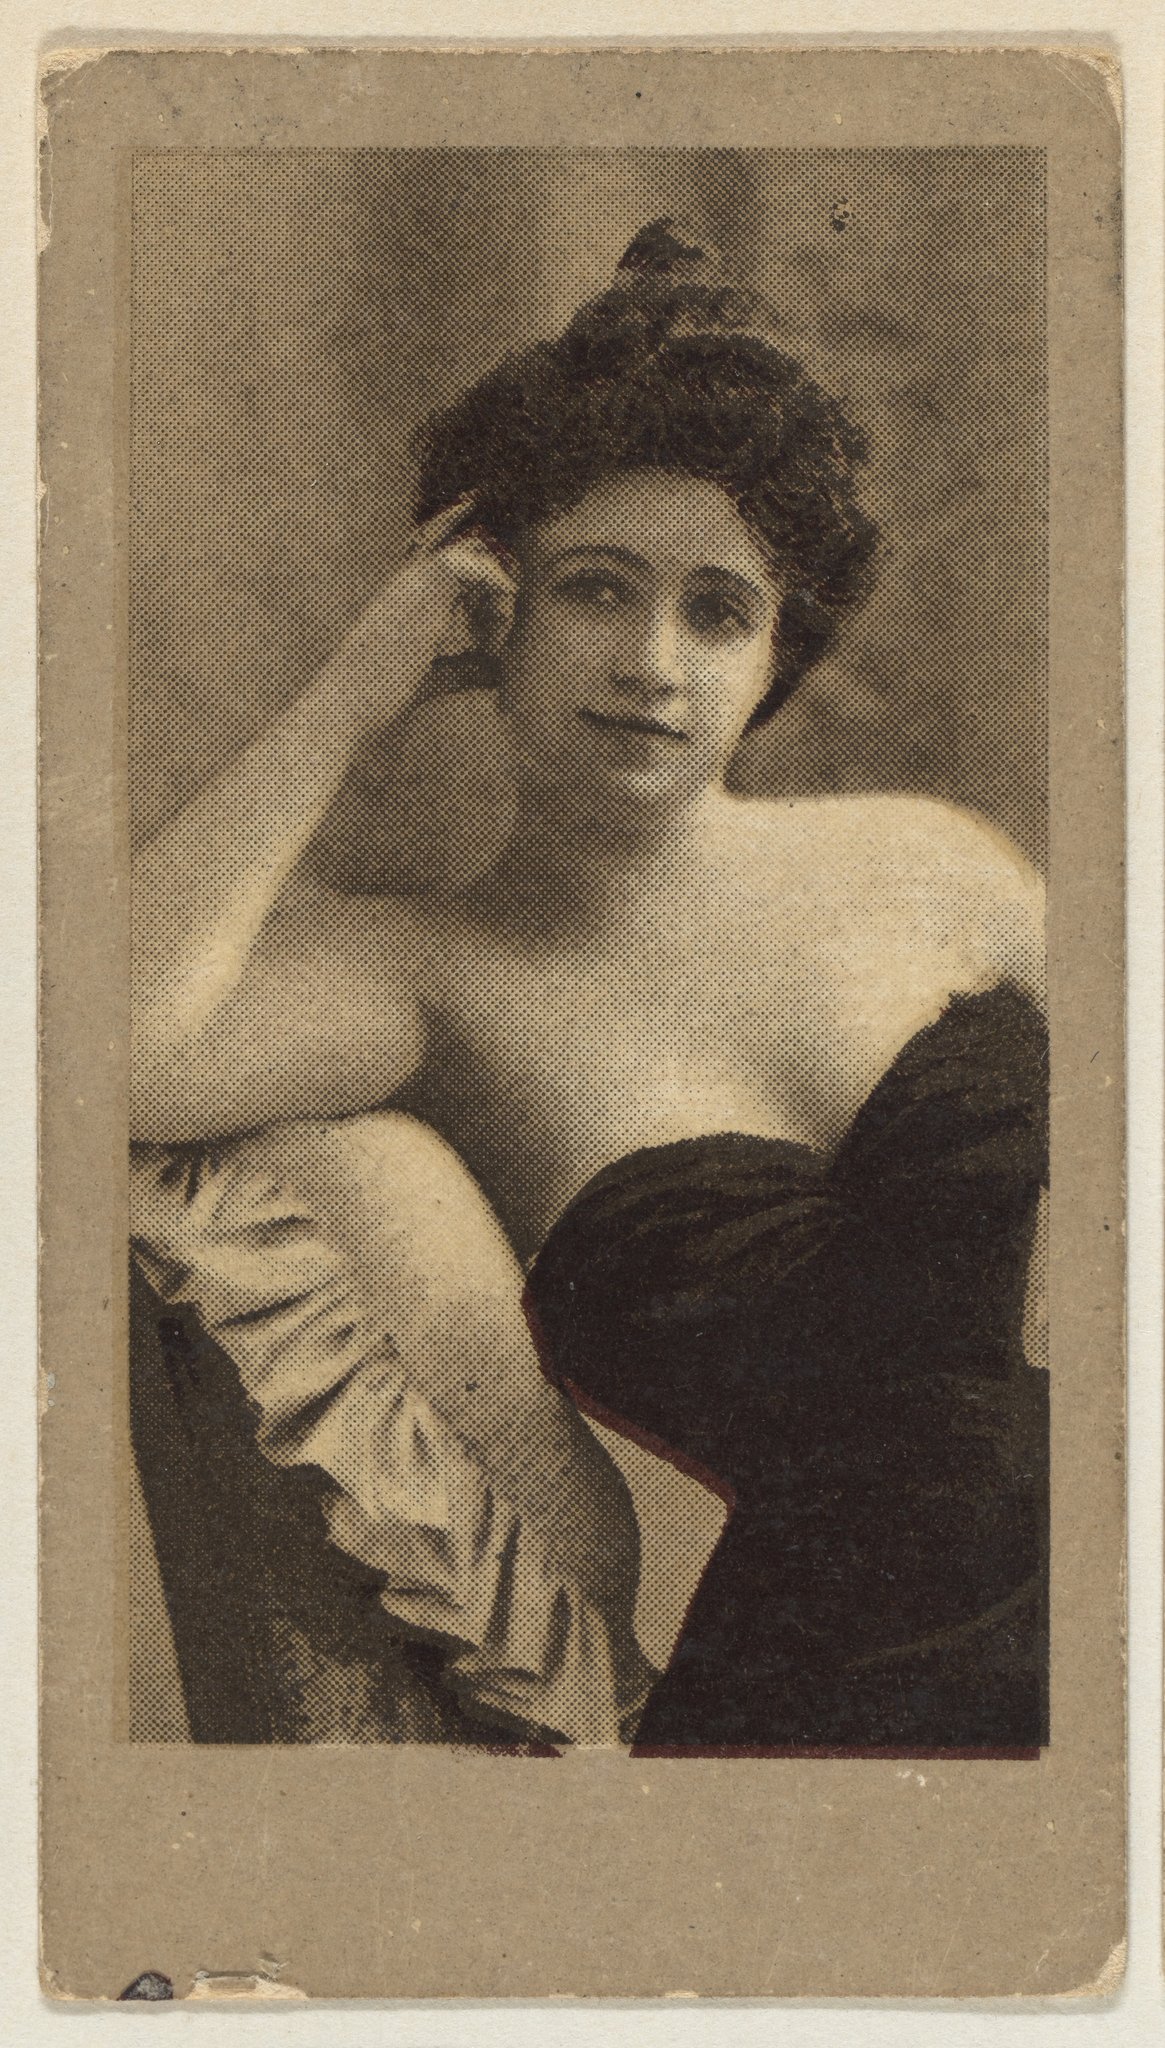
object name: print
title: Portrait of a seated woman, from the "Girls" series (T66), issued with Hunter Dog Cigarros by S. Monday & Sons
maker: s. monday & sons, brooklyn, new york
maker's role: publisher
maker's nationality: american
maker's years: 1850-1950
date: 1900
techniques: photolithograph